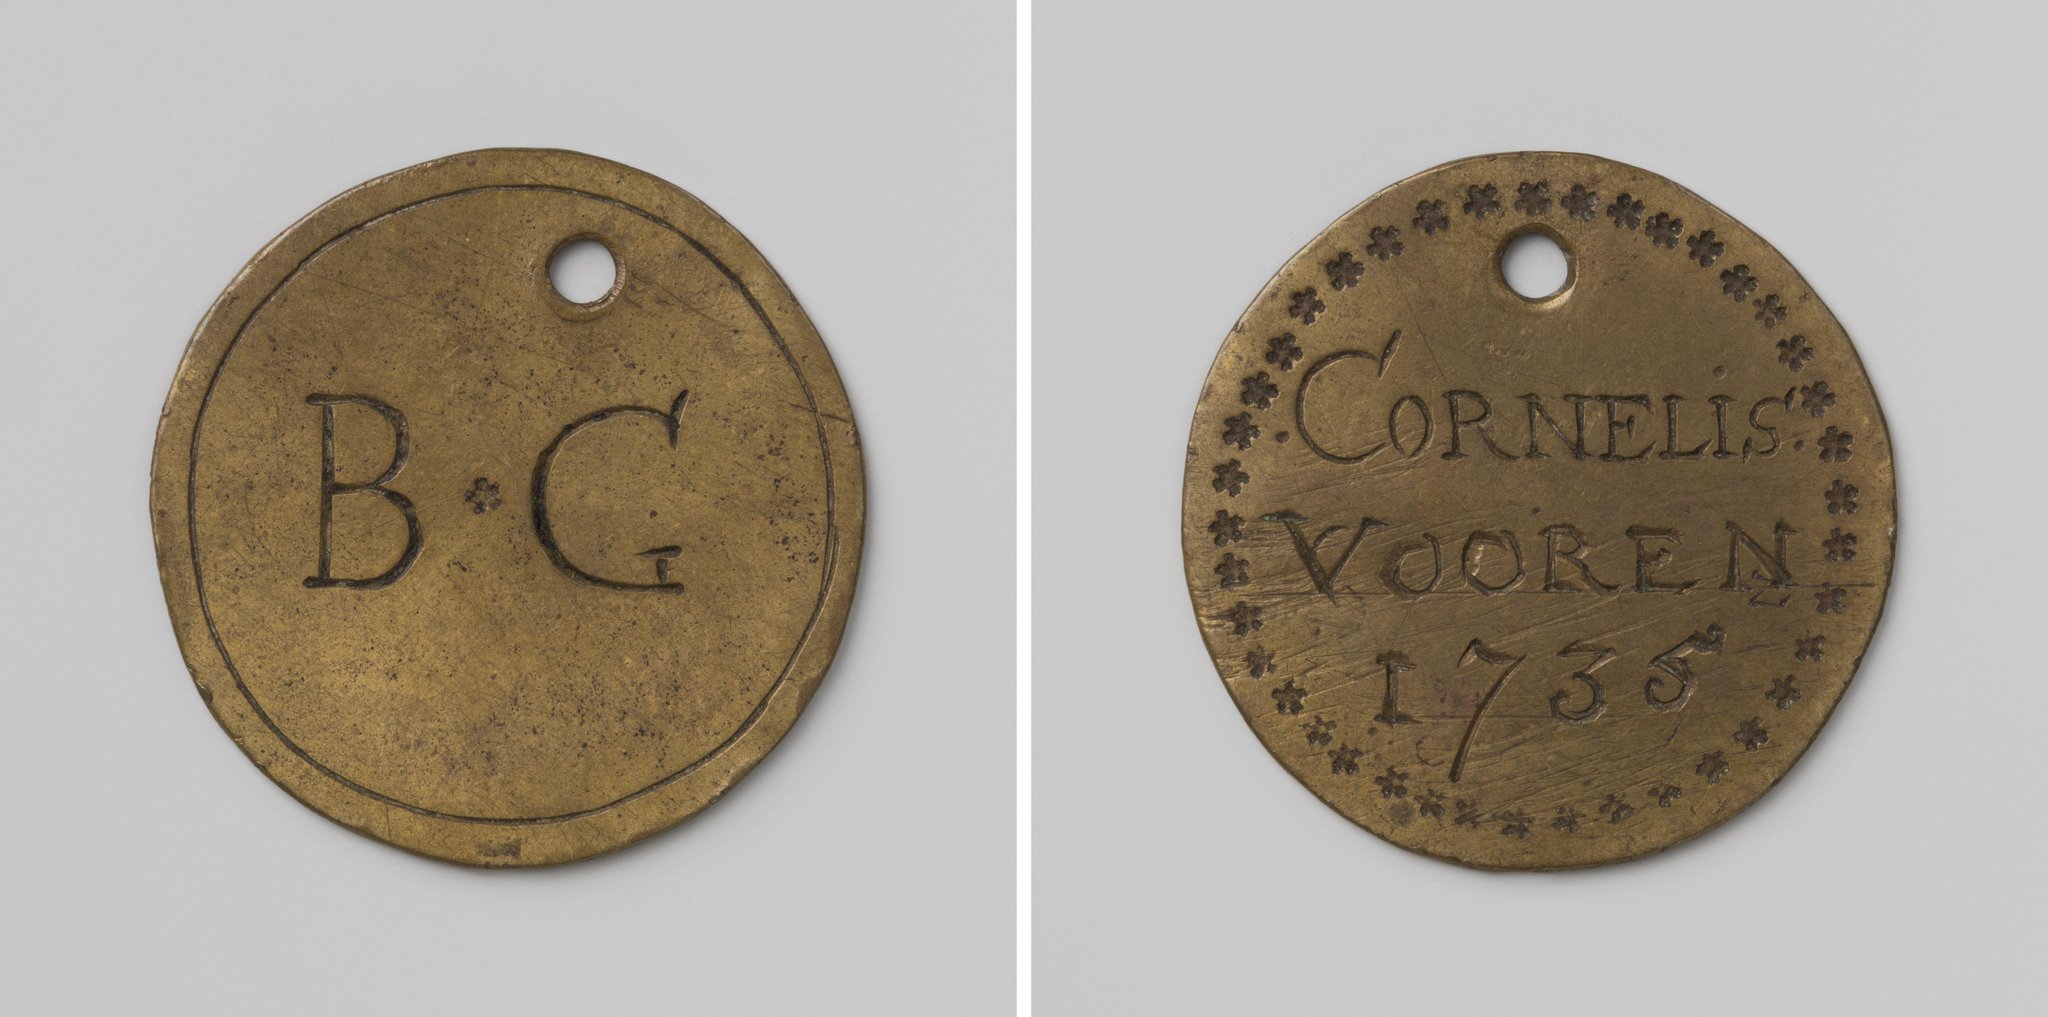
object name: medal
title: Bakkersgilde, gildepenning van Cornelis Vooren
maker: Anonymous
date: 1735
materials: brass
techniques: engraving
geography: netherlands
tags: bakker, vooren, cornelis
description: Messing penning met gat erin. Voorzijde: monogram van letters B en G, gescheiden door sterretje binnen cirkel. Keerzijde: opschrift binnen sterrenkrans